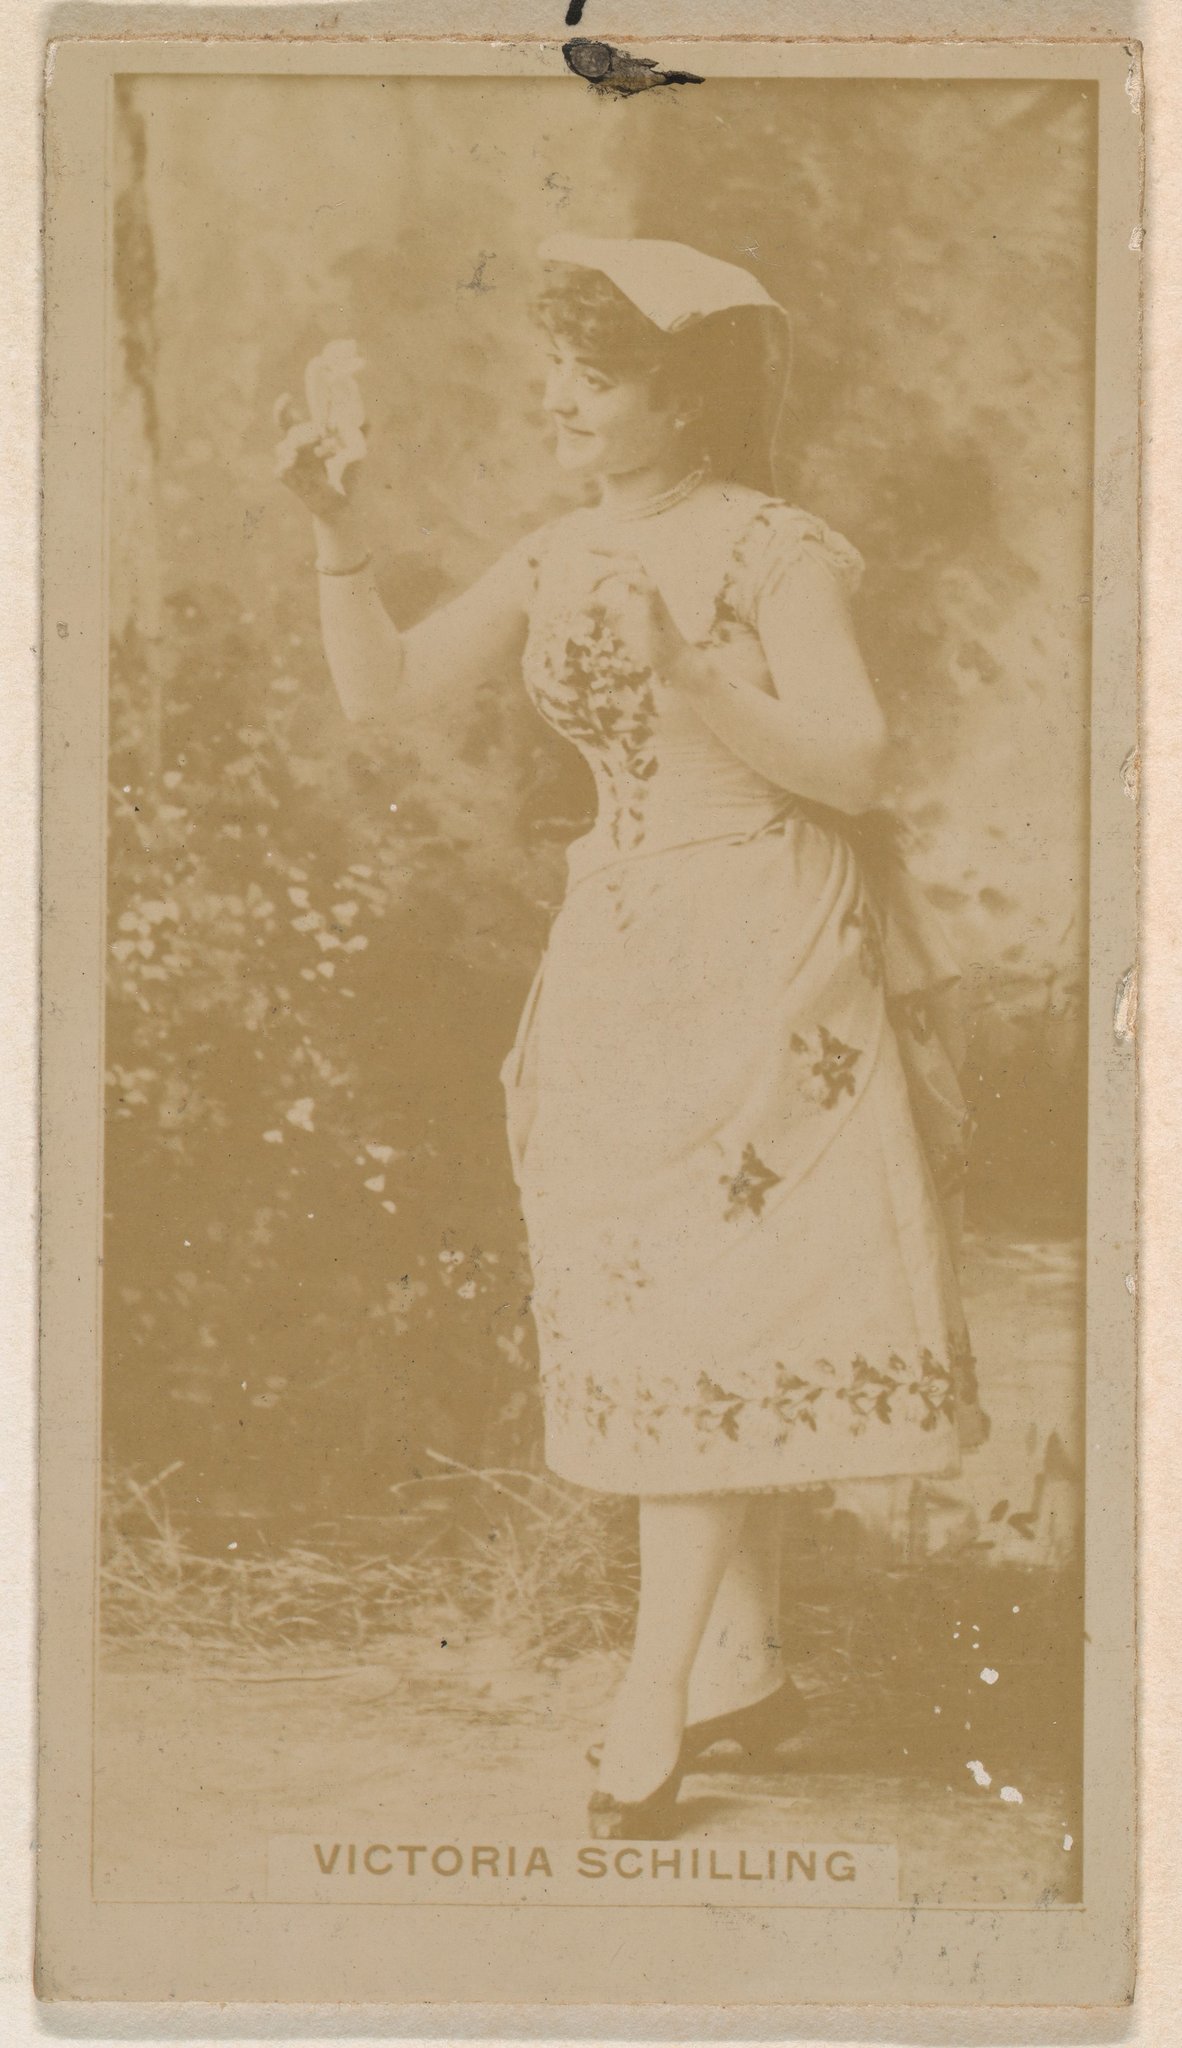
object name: photograph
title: Victoria Schilling, from the Actresses series (N245) issued by Kinney Brothers to promote Sweet Caporal Cigarettes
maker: kinney brothers tobacco company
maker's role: publisher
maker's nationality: american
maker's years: 1869-2011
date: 1890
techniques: albumen silver print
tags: portraits,women,actresses